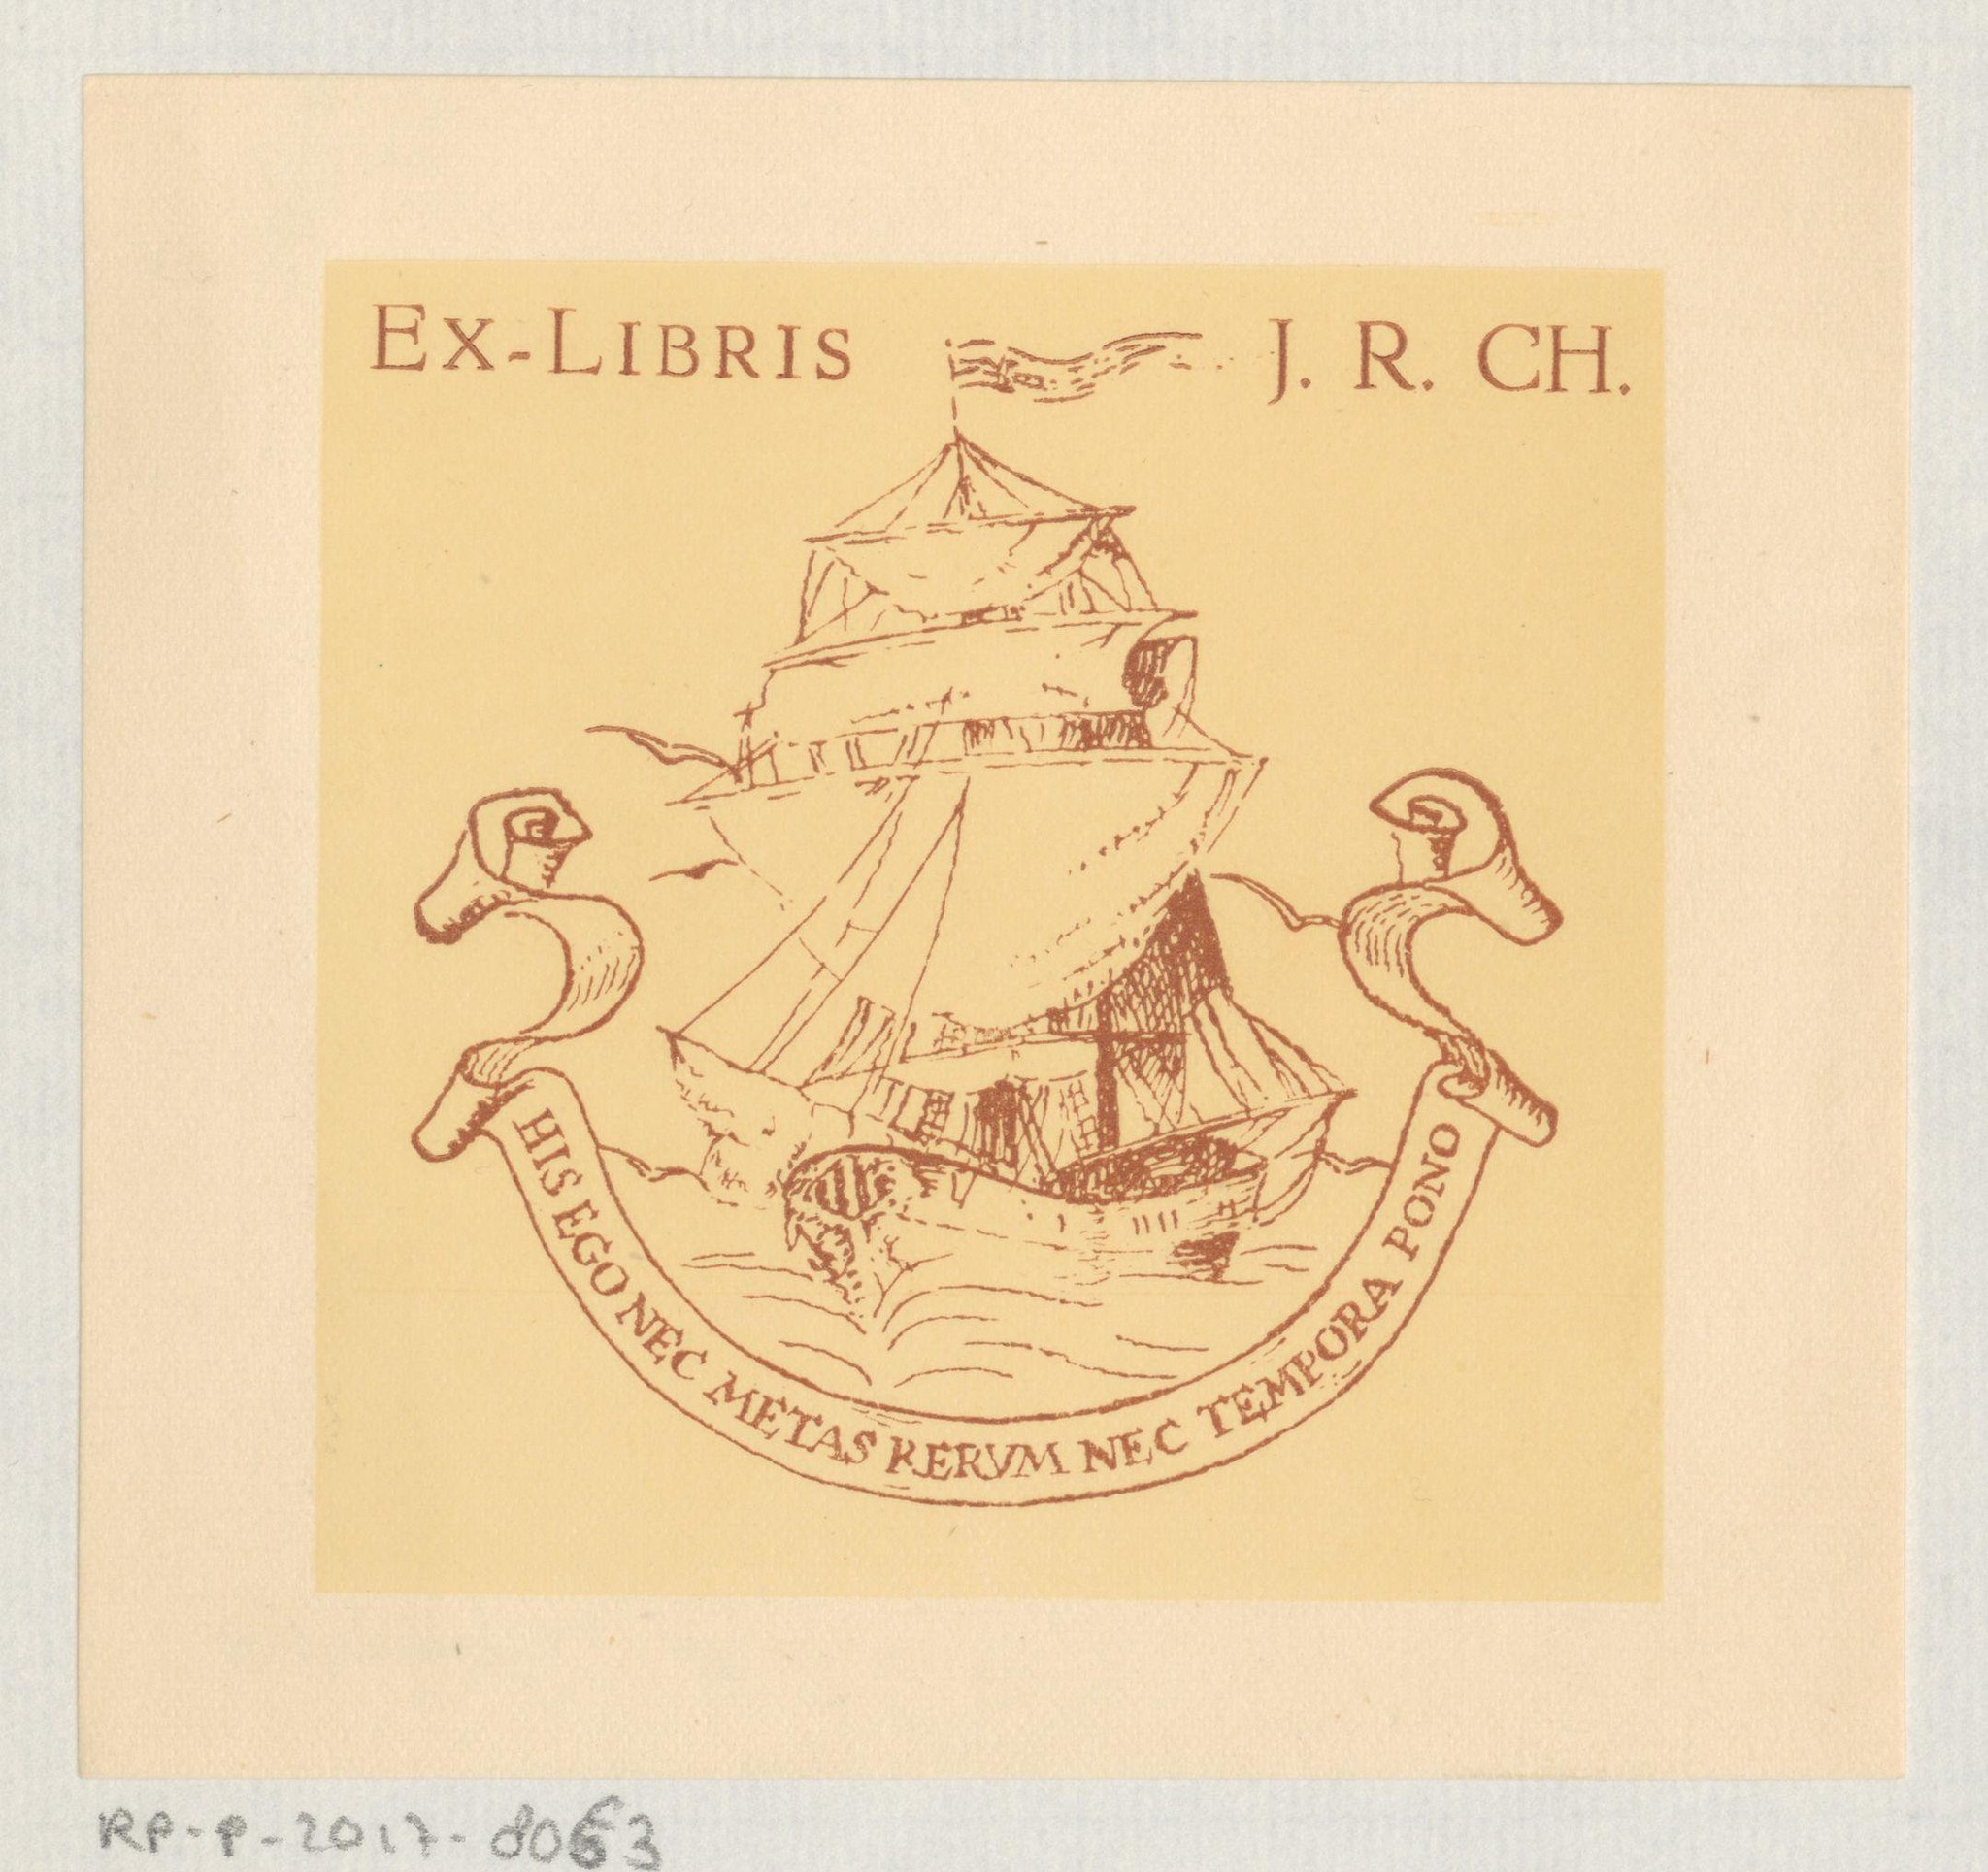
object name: bookplate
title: Ex-libris J.R. Ch.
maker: Anonymous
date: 1942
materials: paper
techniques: printing block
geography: spain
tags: josé rodriguez chaves, sailing-ship, sailing-boat